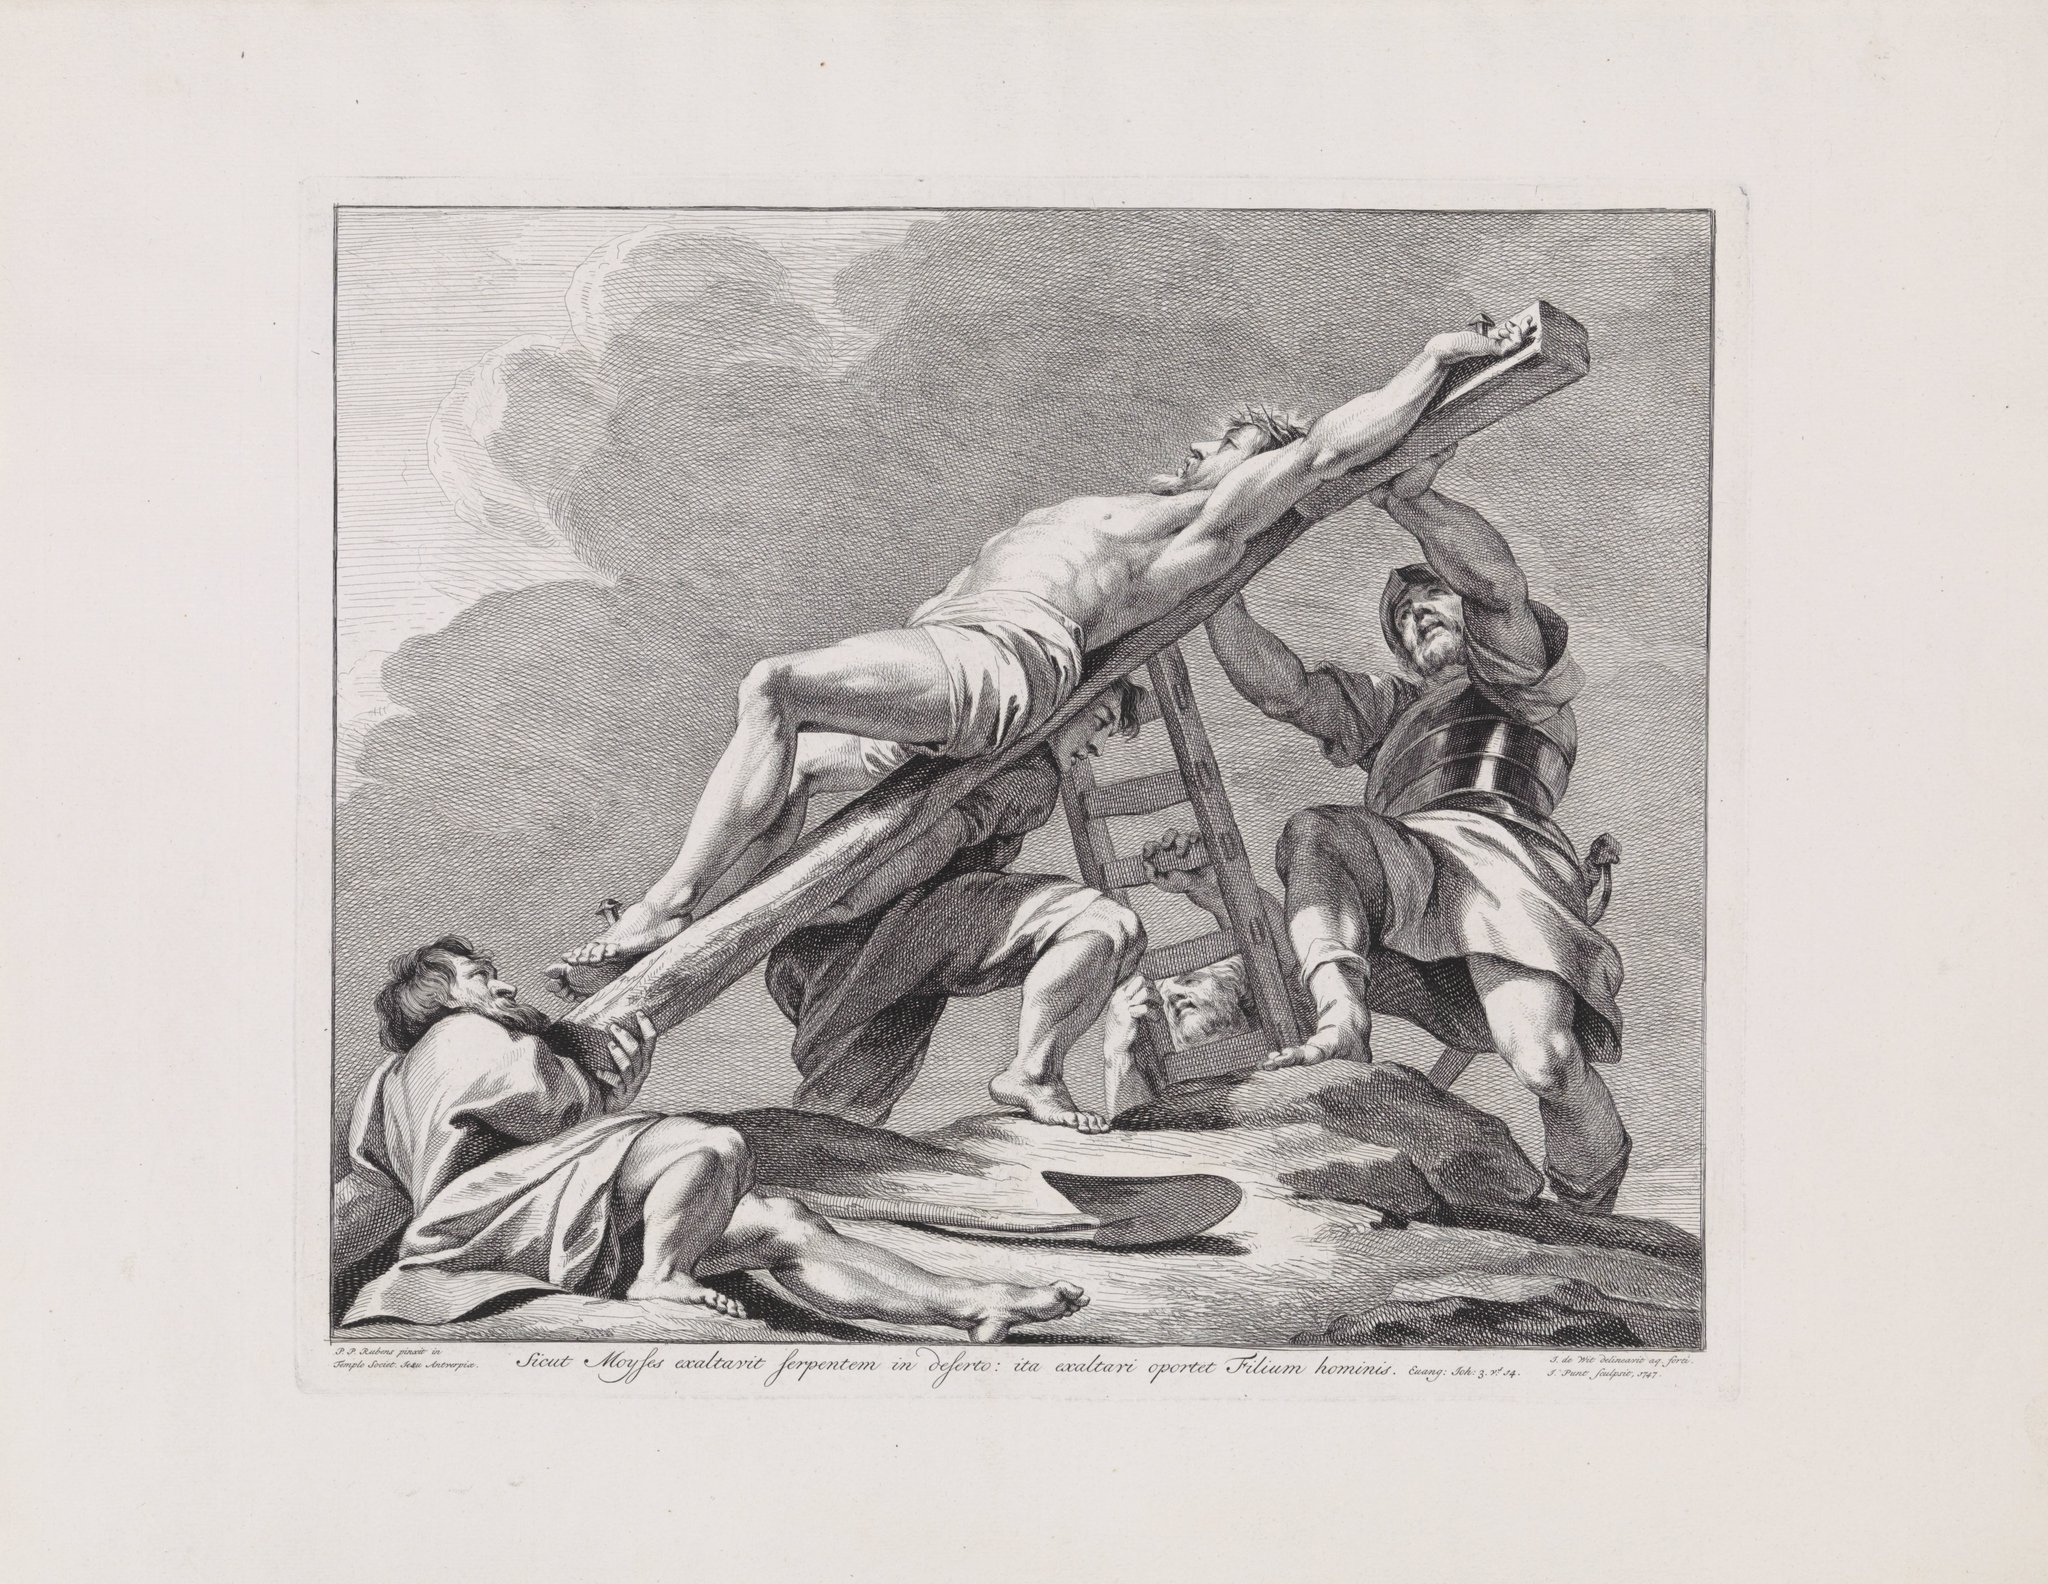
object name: print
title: Kruisoprichting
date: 1747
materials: paper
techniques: engraving, etching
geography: amsterdam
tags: raising of the cross to which christ is nailed already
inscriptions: collector's mark: Lugt 240, date: ‘1747’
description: Vier mannen, waaronder één soldaat, richten het kruis met Christus op. Onder de rechthoekige voorstelling een vers in het Latijn uit Joh. 3:14.